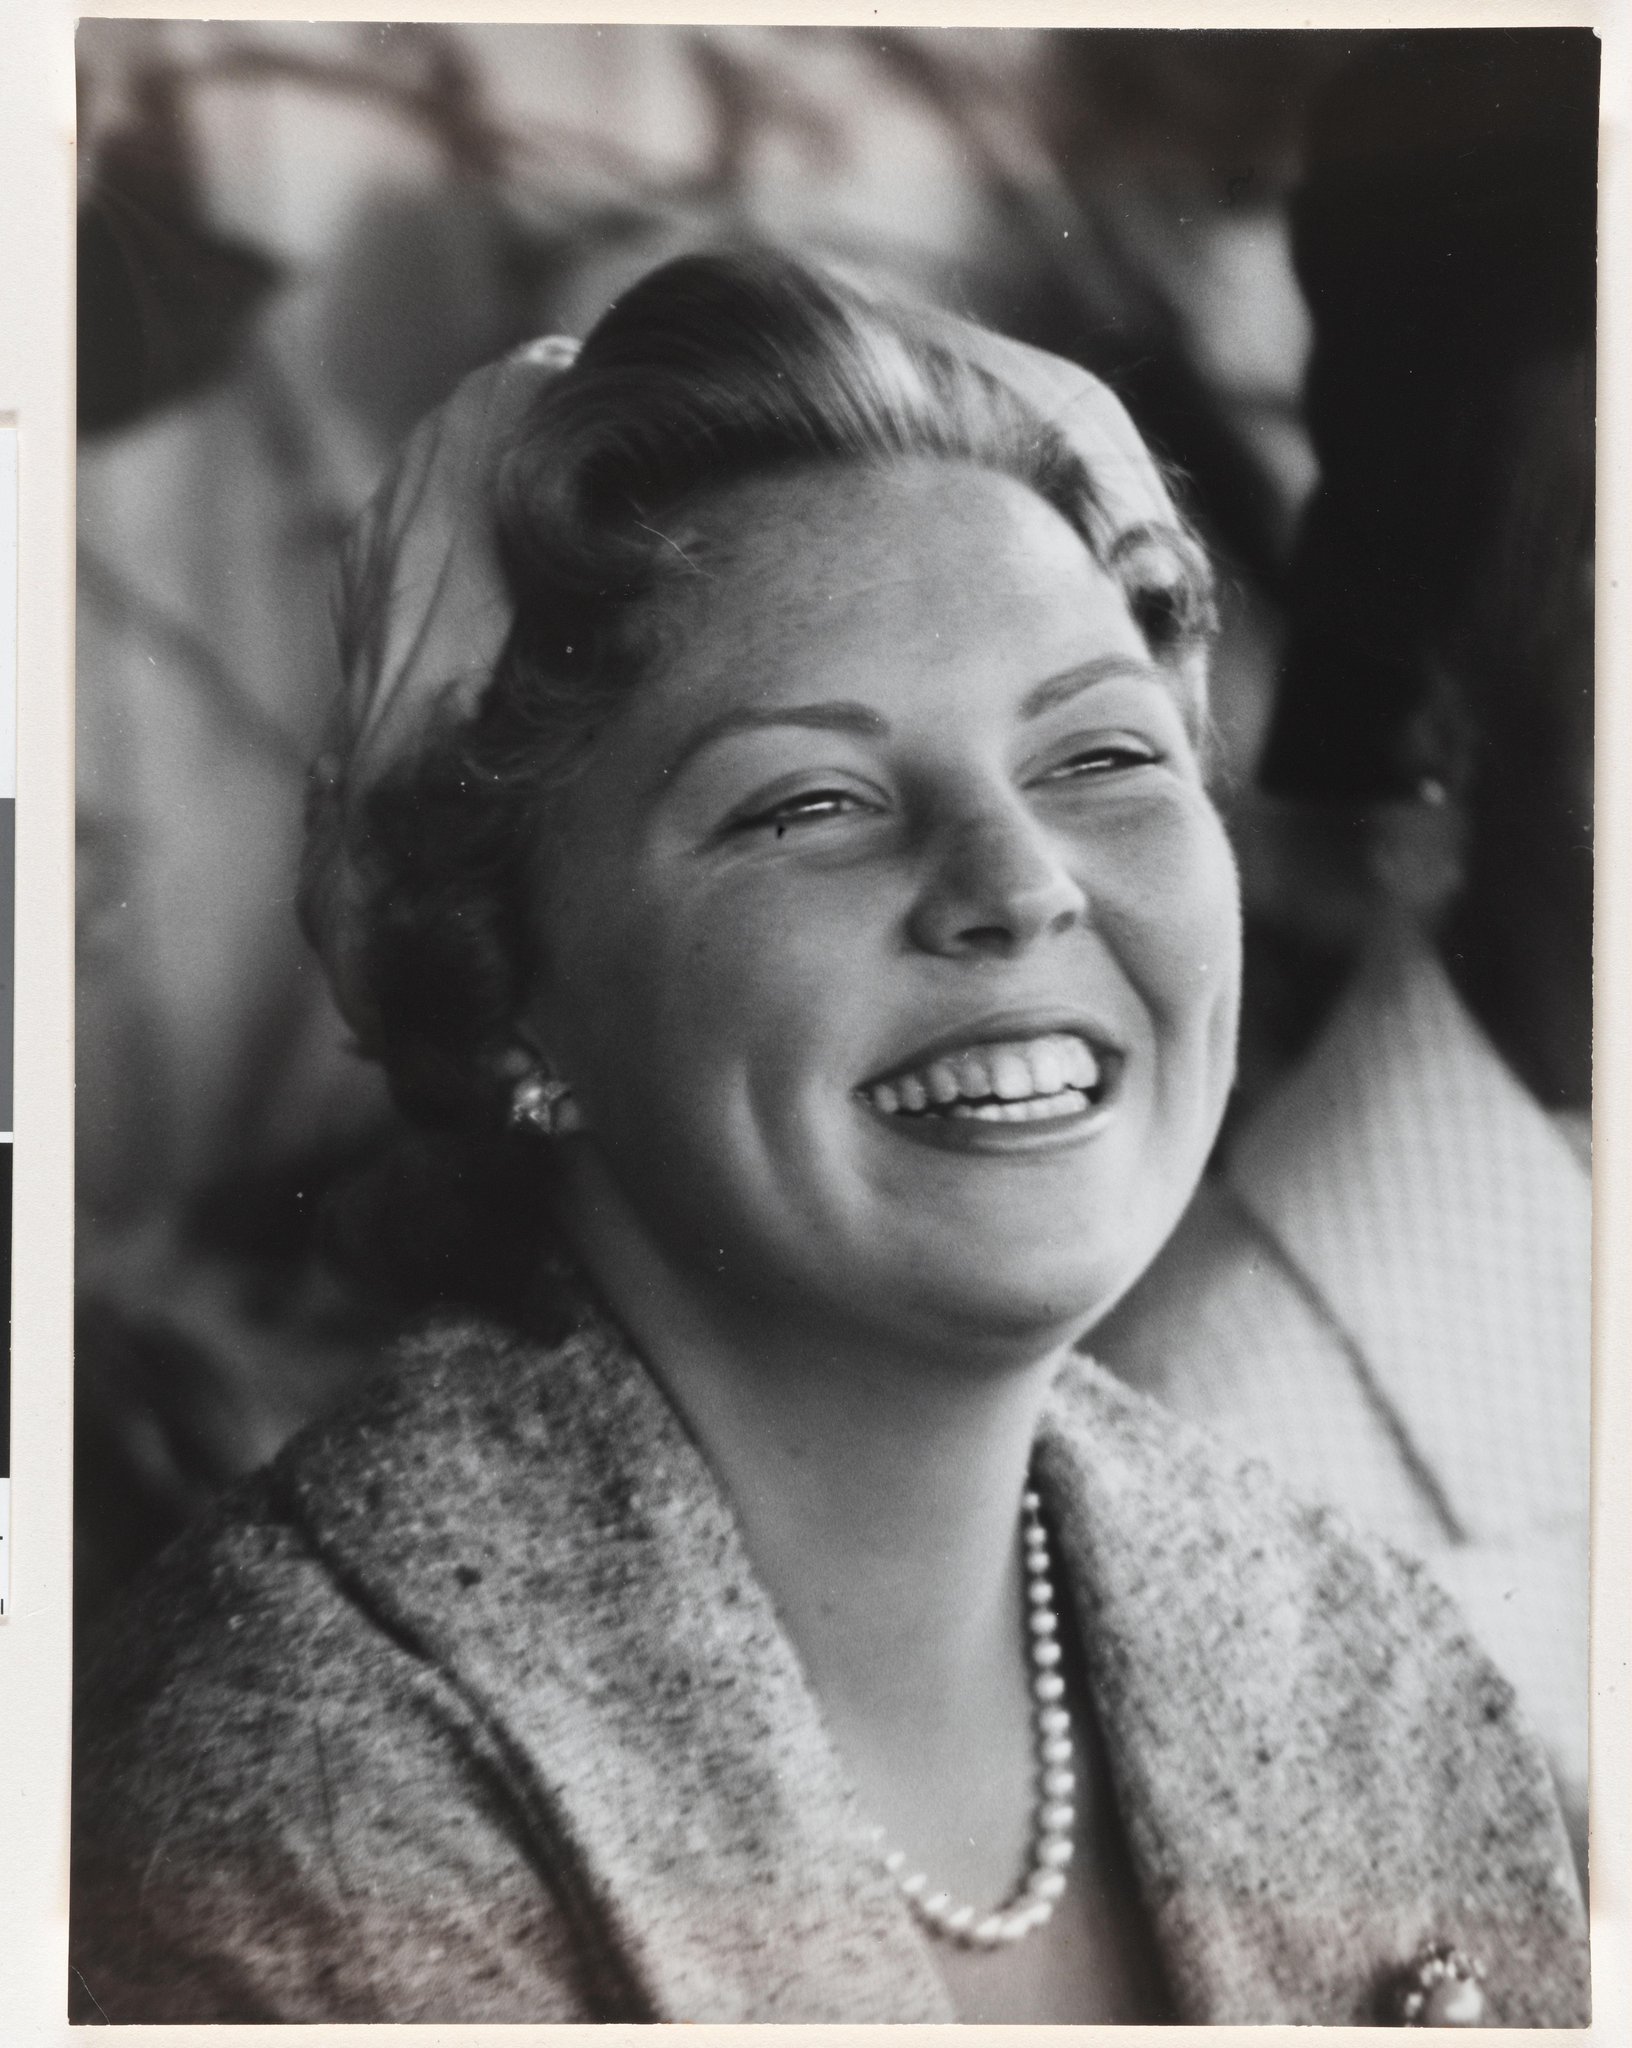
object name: photograph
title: H.K.H.Prinses Beatrix is dinsdagmorgen op Schiphol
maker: harry pot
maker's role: fotograaf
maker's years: 1929-1996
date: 1959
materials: paper, photographic support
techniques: gelatin silver print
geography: netherlands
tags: beatrix (koningin der nederlanden)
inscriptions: annotation: ‘H.K.H.Prinses Beatrix is dinsdagmorgen op Schiphol / aangekomen na een bezoek aan de Verenigde Staten. / Na aankomst op de luchthaven gaf H.K.H.Prinses / Beatrix een persconferentie. // foto:H.K.H.Prinses Beatrix tijdens de persconferentie. / F O T O-A N E F O/Harry Pot. 22-9-1959’